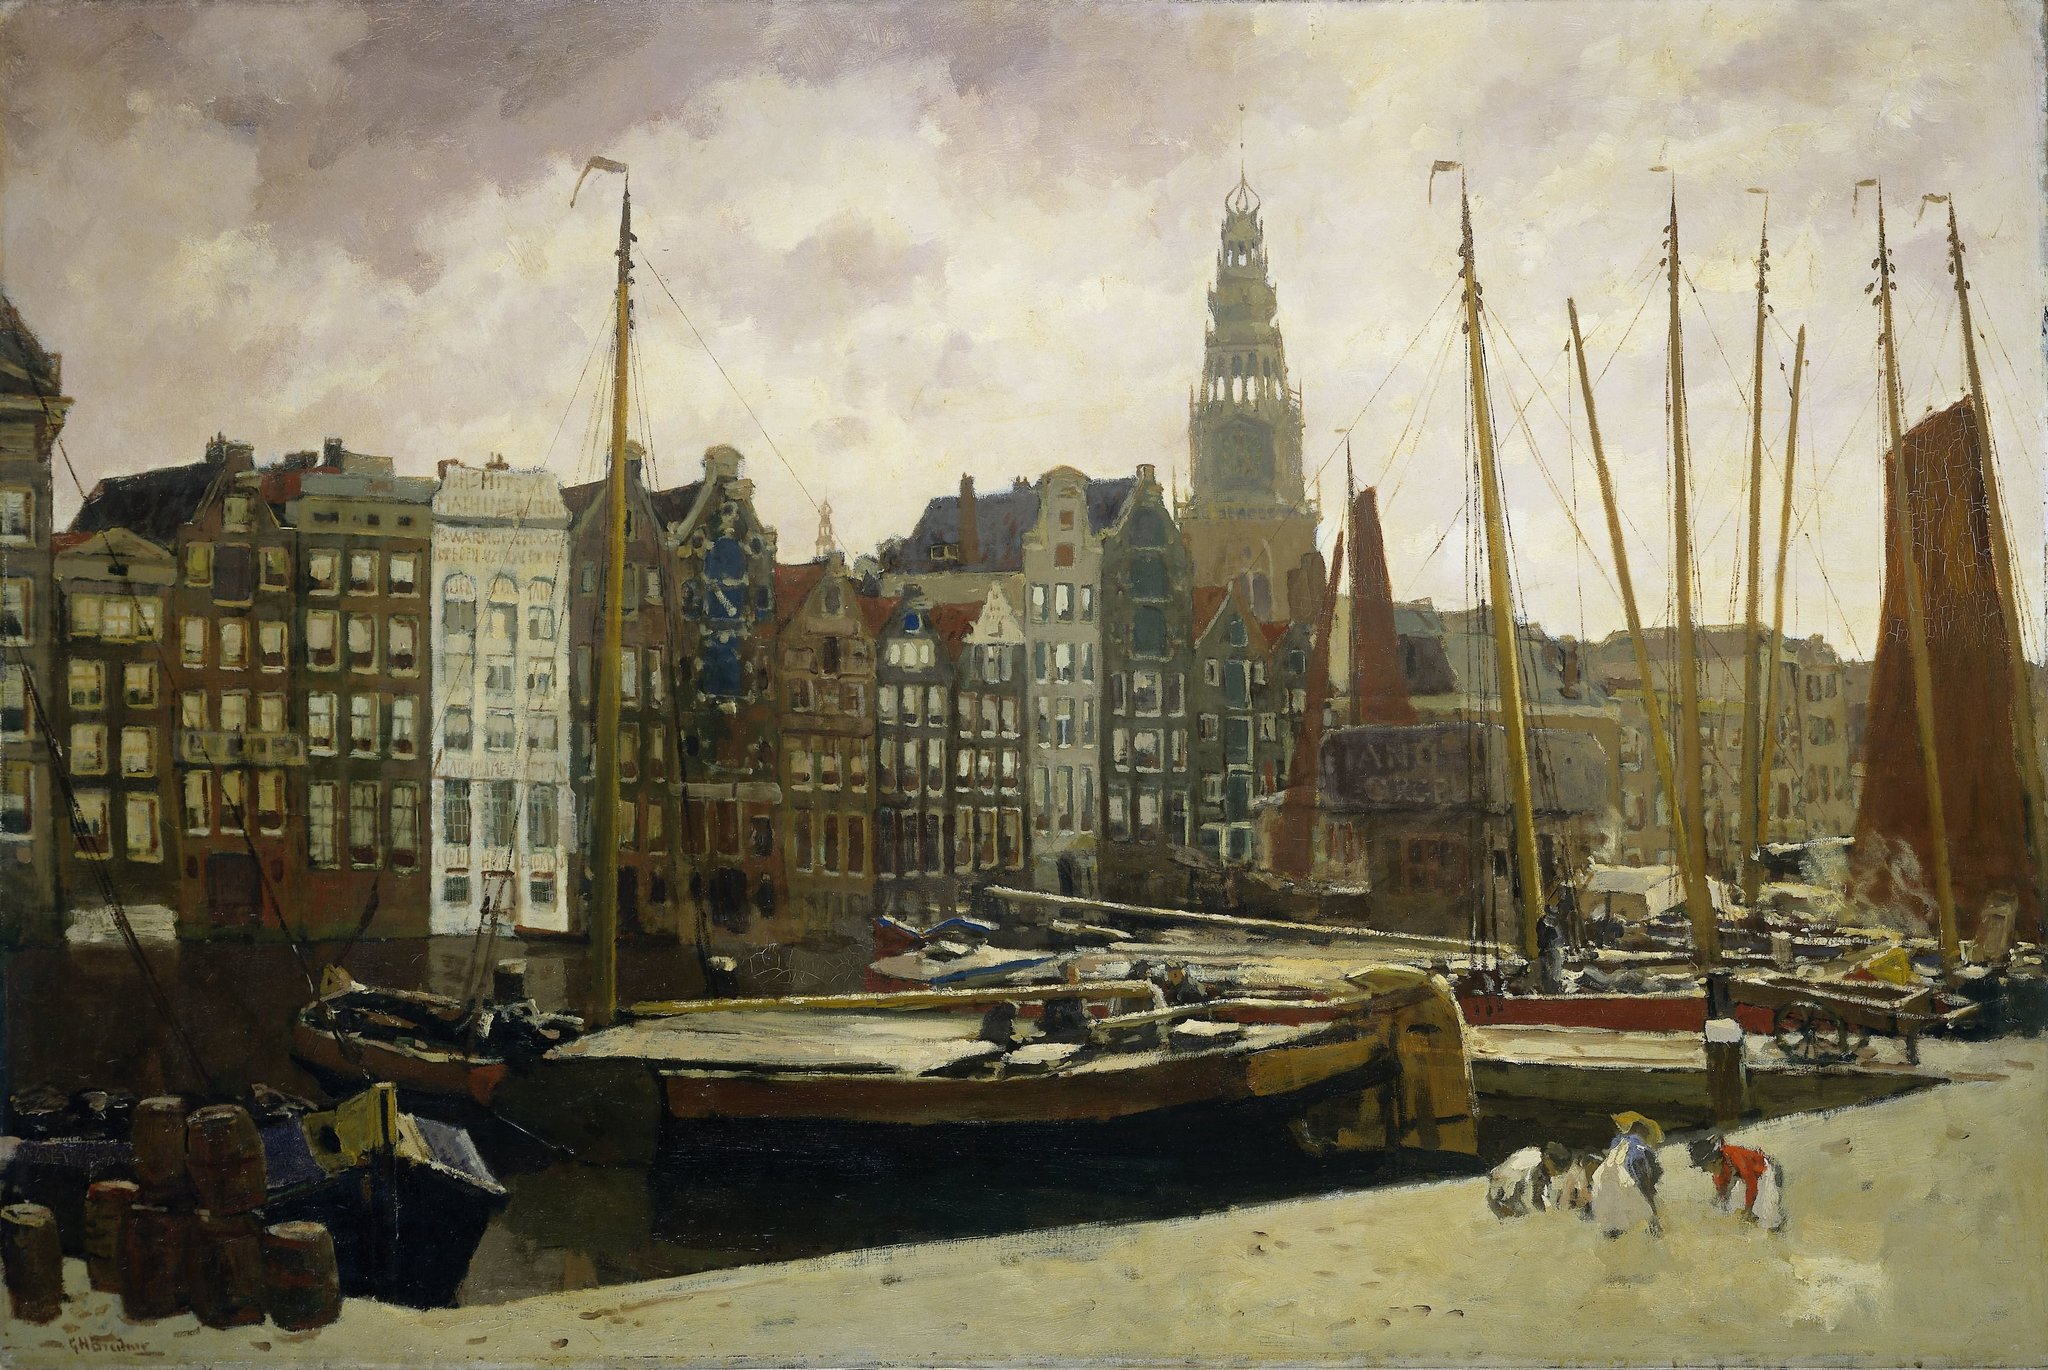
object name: painting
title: The Damrak, Amsterdam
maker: george hendrik breitner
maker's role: draughtsman, painter, print maker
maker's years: 1857-1923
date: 1903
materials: canvas, oil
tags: quay (+ city(-scape) with figures, staffage)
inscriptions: signature: ‘G.H. Breitner’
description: Since 1889 Amsterdam’s Centraal Station has blocked the link between the Damrak (a straight stretch of the Amstel River) and the IJ (the city’s former bay). Once an open body of water, the Damrak was turned into an inner harbour. Here Breitner depicted the houses on the Warmoesstraat and the Oudekerk tower. He used a photograph, which included the Koopmansbeurs (Commodity Exchange) – then under construction. In his painting, this building was completely omitted.